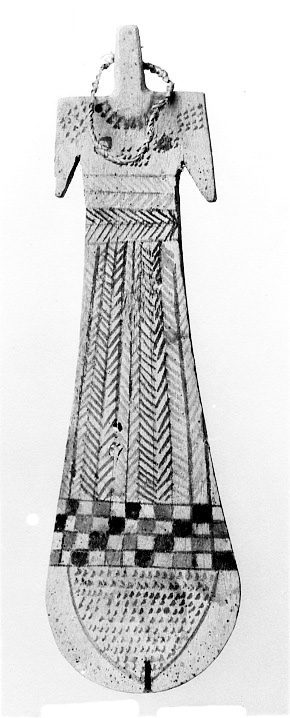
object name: paddle doll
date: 2030-1981 BCE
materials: linen, paint, wood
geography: egypt